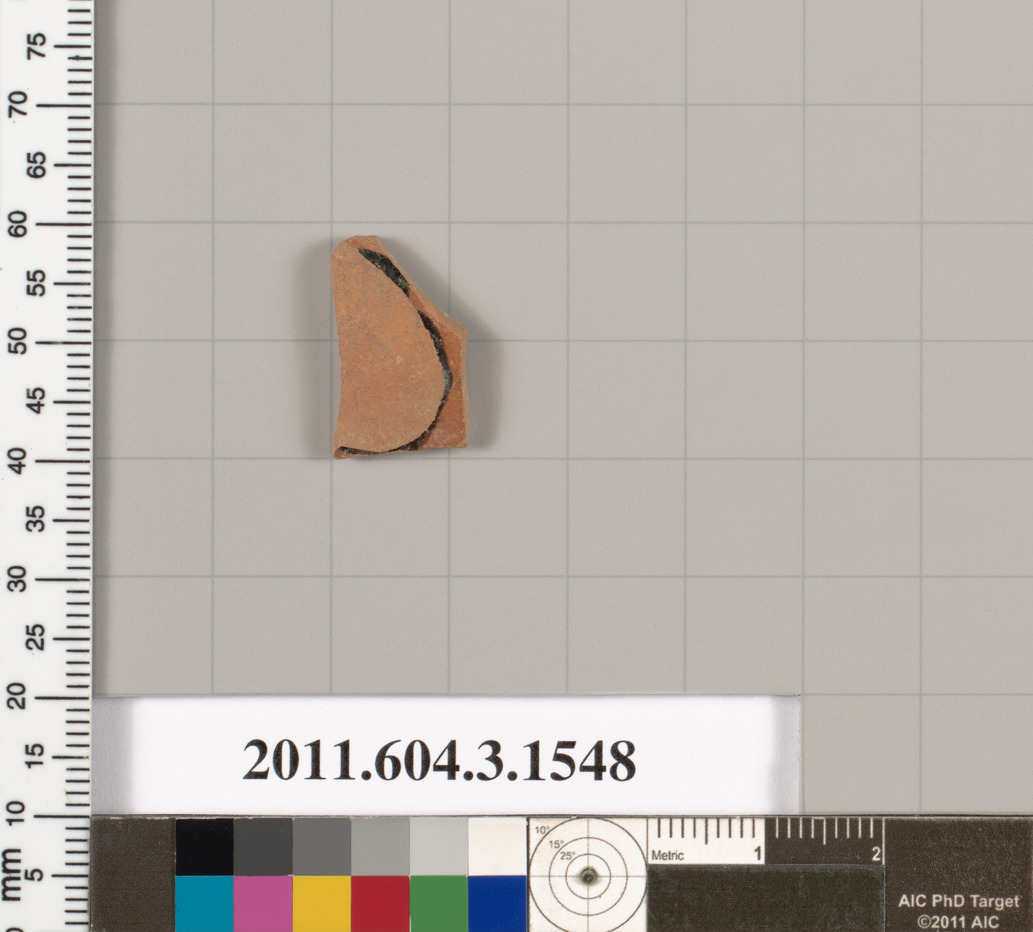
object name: kylix fragment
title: Terracotta fragment of a kylix (drinking cup)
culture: greek, attic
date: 550-526 BCE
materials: terracotta